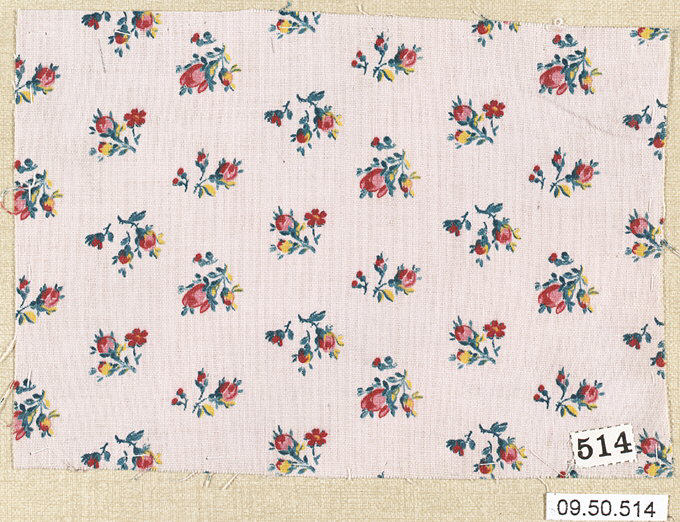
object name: piece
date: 1801-1900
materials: cotton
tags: flowers,leaves